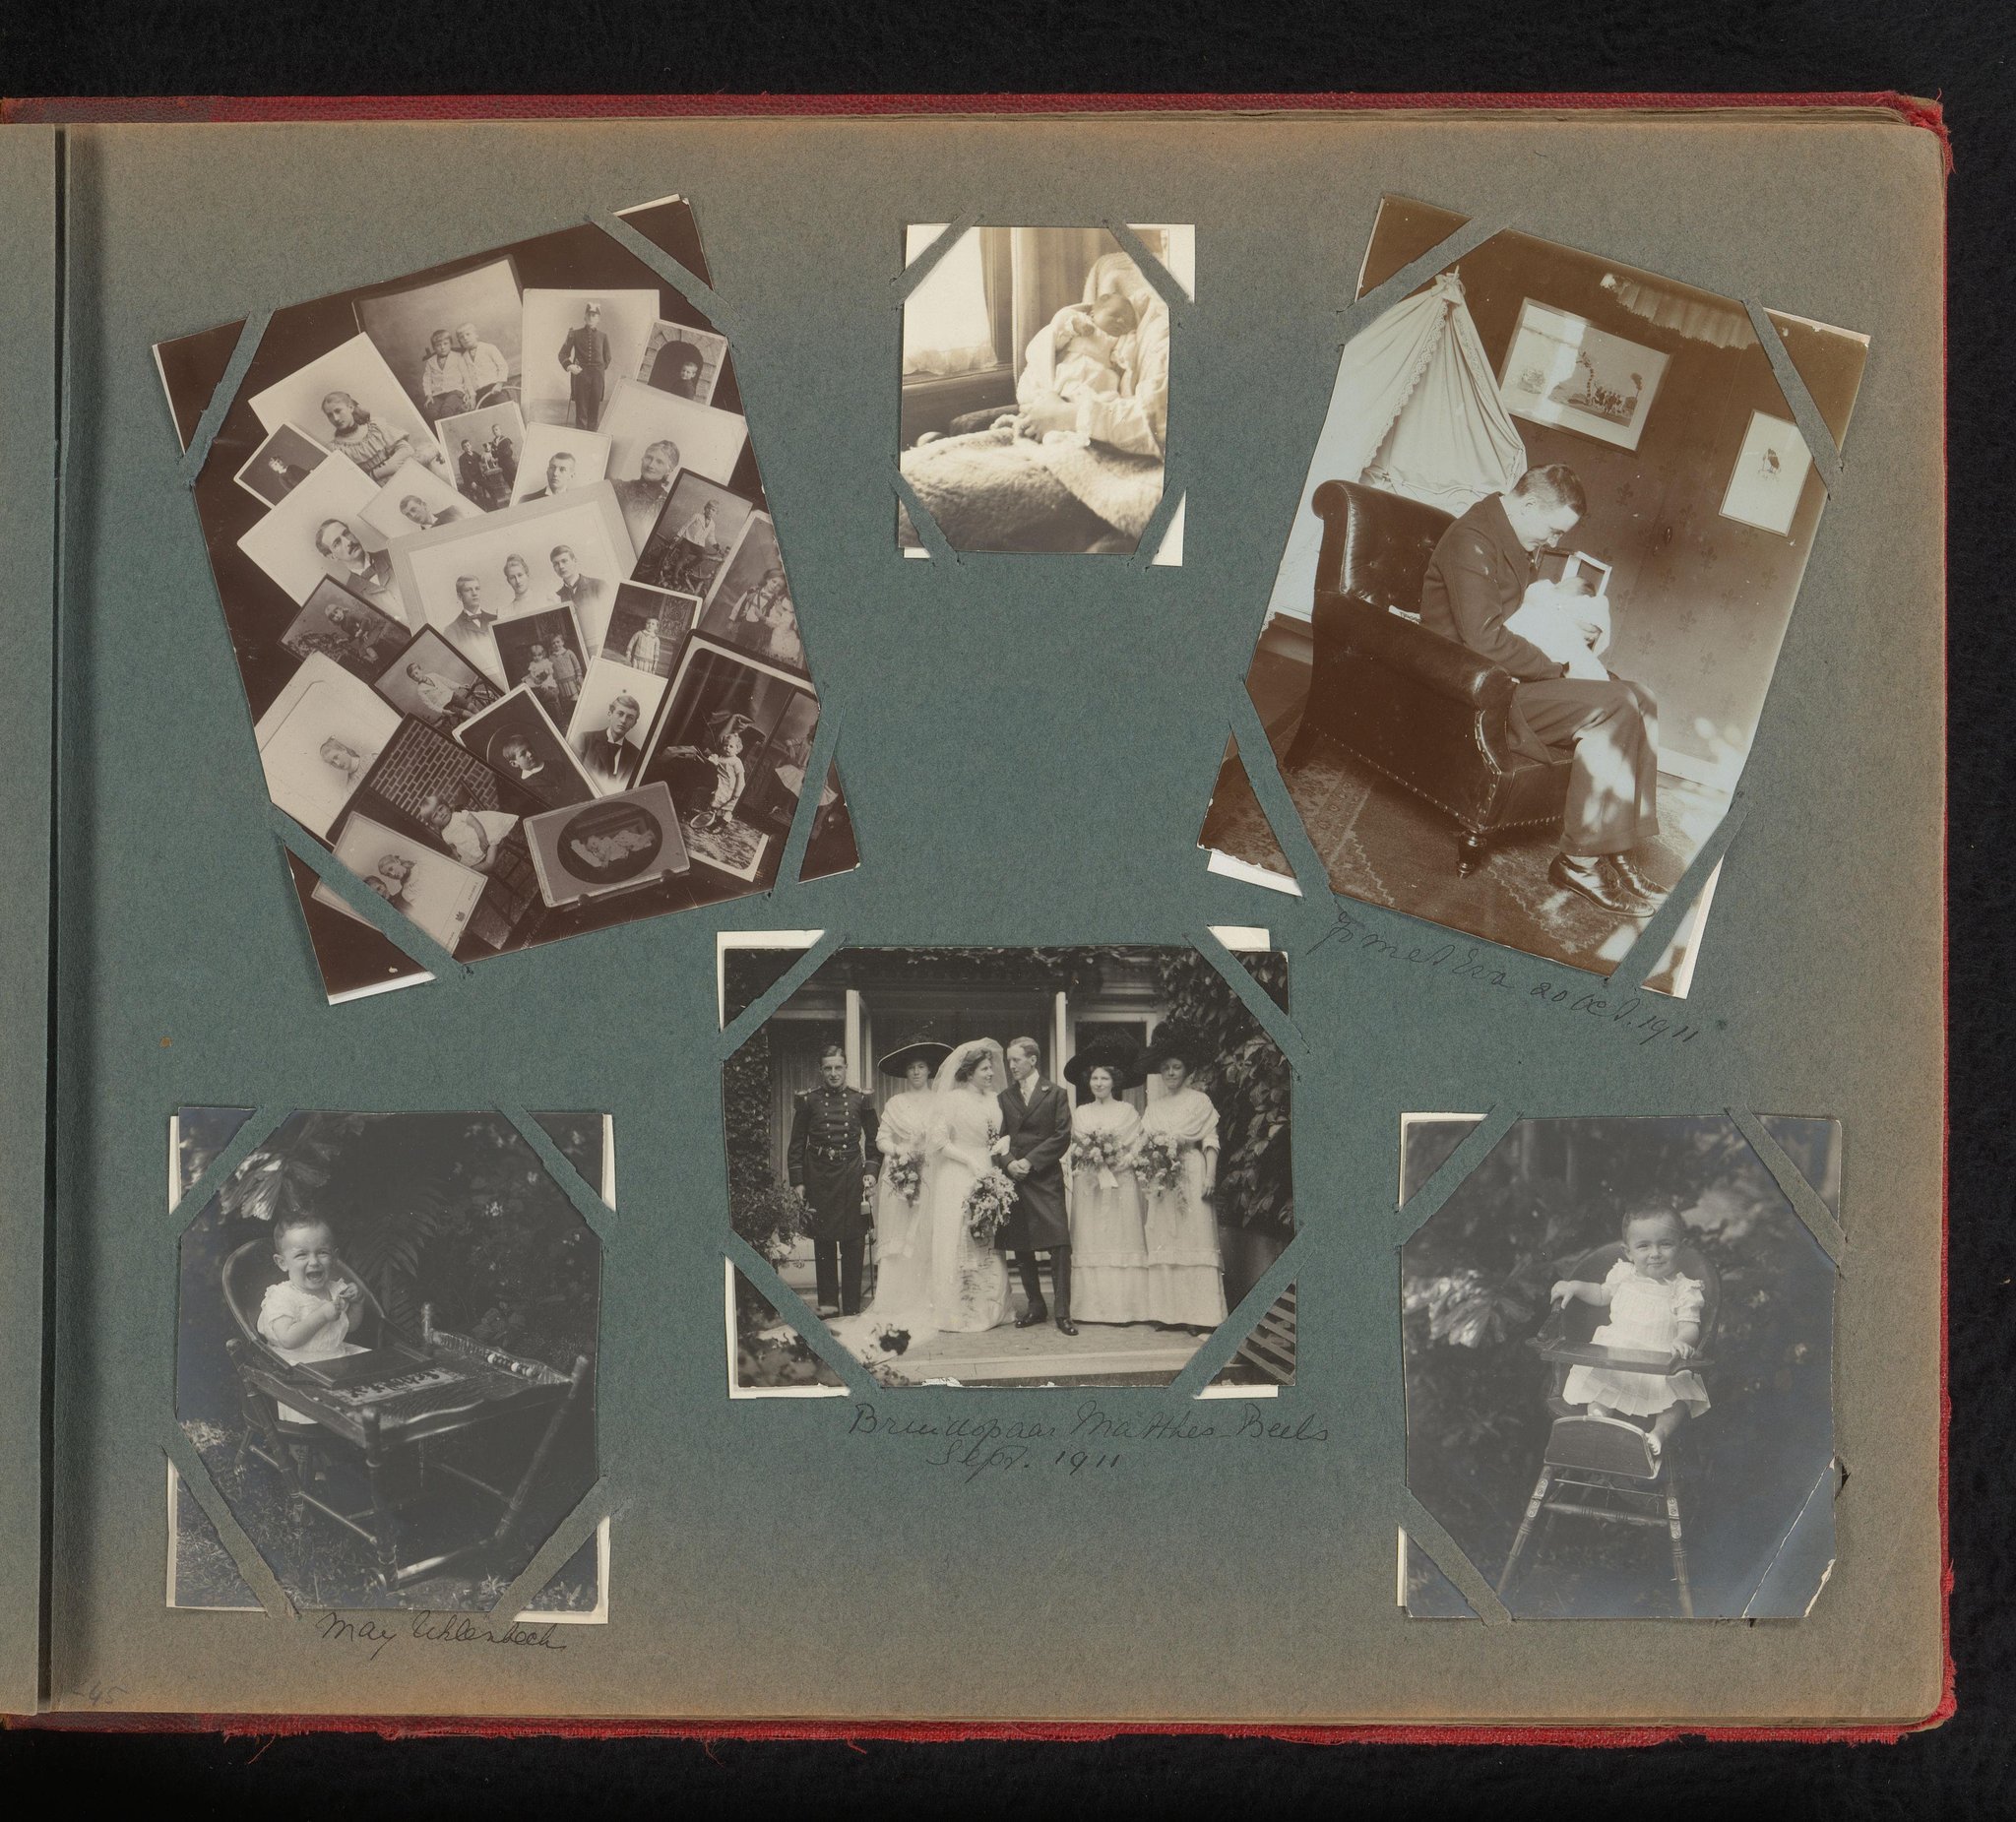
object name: photograph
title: Eva Boelen met haar vader, Joan Boelen, het bruidspaar Hester en Rudolf Matthes en een compositie van familiefoto's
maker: charlotte alida boelen-matthes (lot)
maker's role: amateurfotograaf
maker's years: 1889-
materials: paper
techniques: gelatin silver print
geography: netherlands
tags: amsterdam, eva charlotte pennink-boelen, joan gerard boelen, bride and groom in wedding-dress, infant, baby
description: Deze foto's zijn onderdeel van een album.